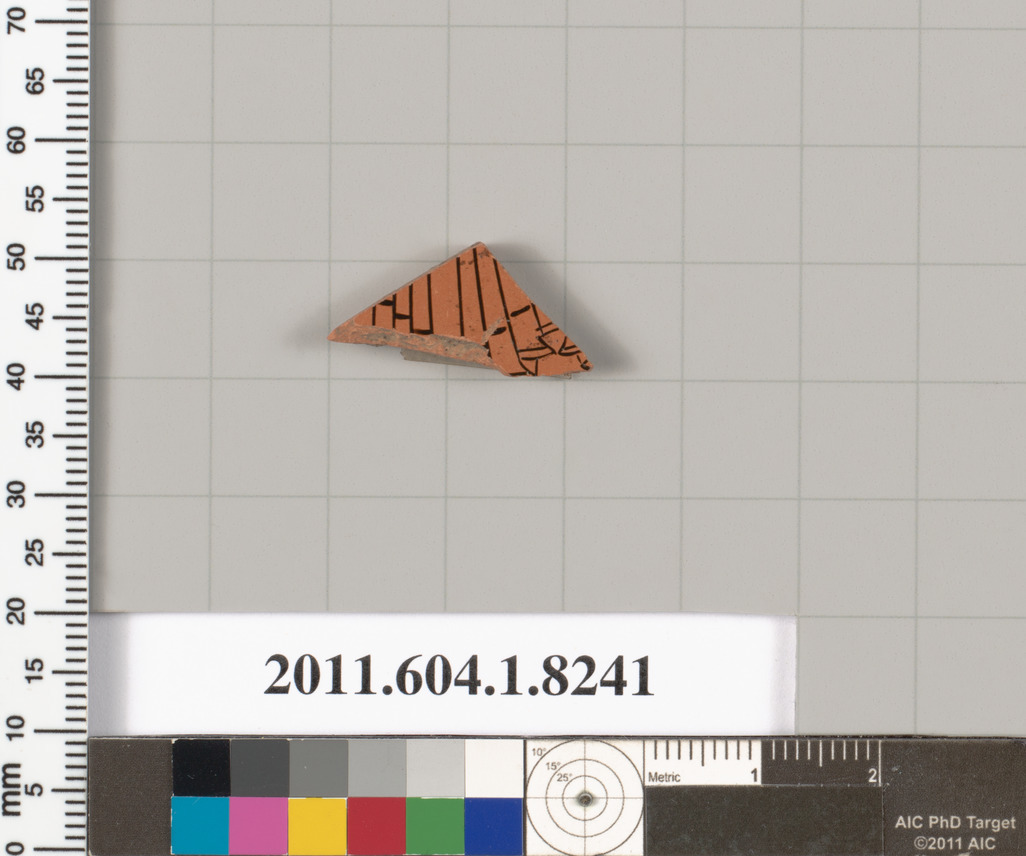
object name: kylix fragment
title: Terracotta fragment of a kylix (drinking cup)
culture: greek, attic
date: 520-510 BCE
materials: terracotta